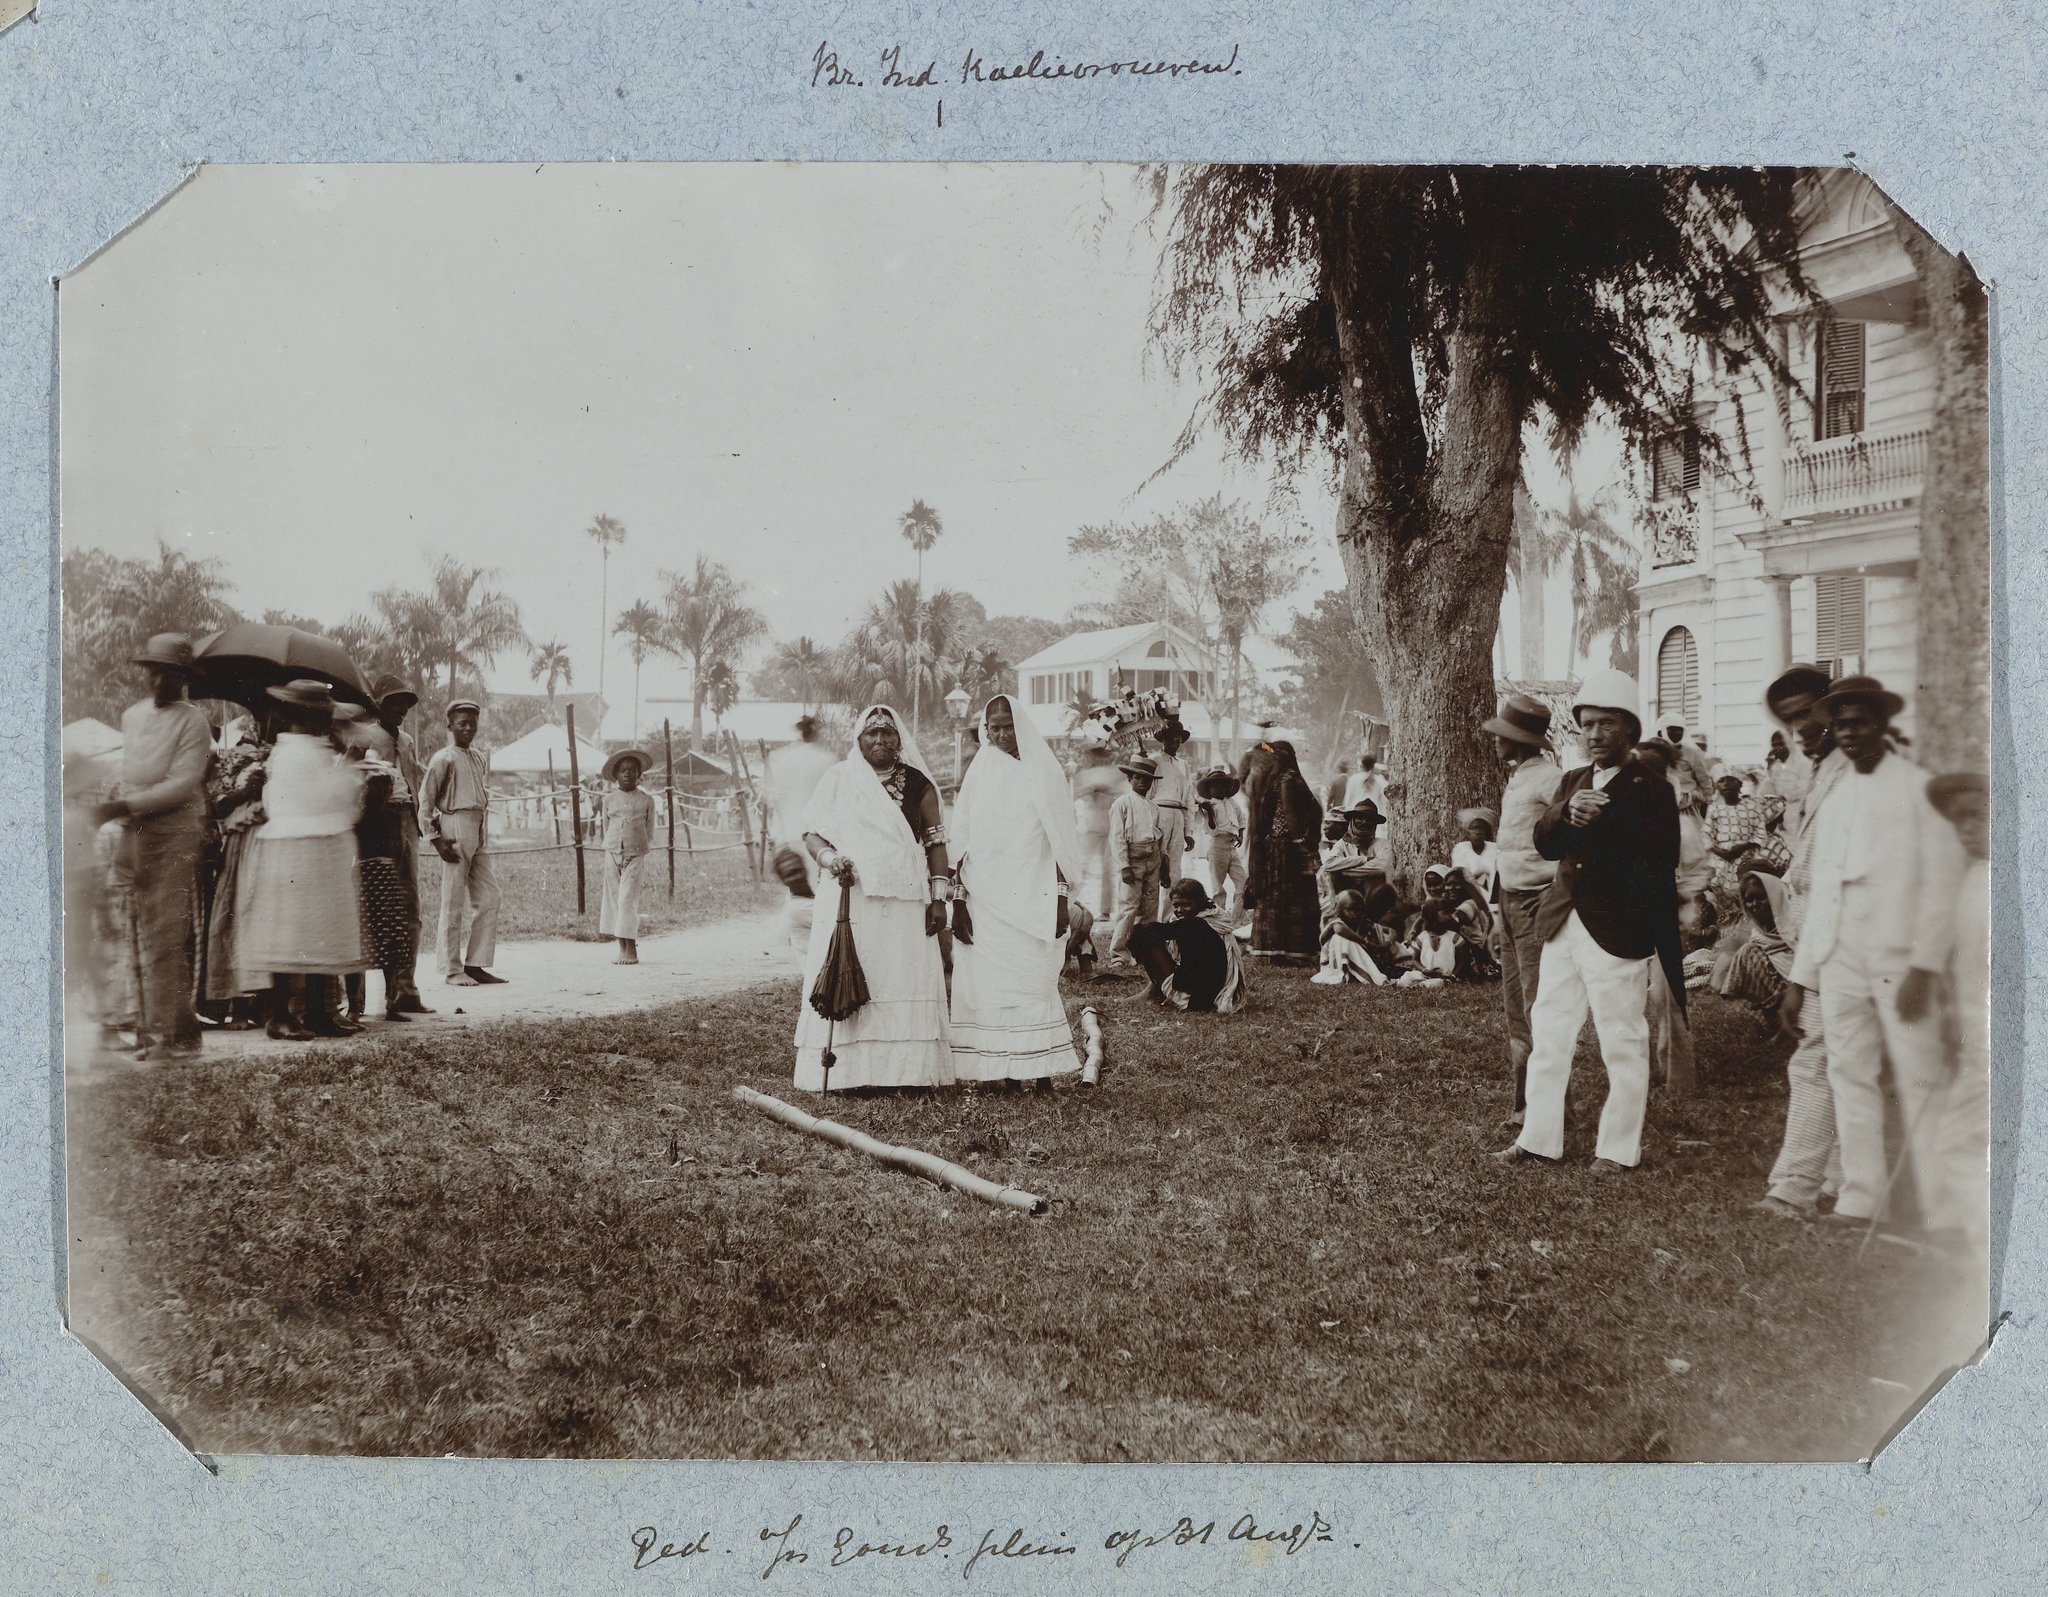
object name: photograph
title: Photographs of Paramaribo and Maroon Village on the Saramacca River, Suriname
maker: théodore van lelyveld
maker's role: painter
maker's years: 1867-1954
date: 1895-1898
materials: photographic support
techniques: collodion silver print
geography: suriname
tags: public festivities on the occasion of royal events, working class, labourers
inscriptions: inscription: ‘Ged. v/h Gouvs.plein op 31 Augs. / Br. Ind. Koelievrouwen’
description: Van Lelyveld left for Suriname as a 28-year old to work as the assistant to the Dutch governor Titus van Asch van Wijck. This presented him with every opportunity to photograph all of the layers of the Surinamese society in the farthest nooks and crannies. Like a seasoned photojournalist he recorded all of the districts of Paramaribo, celebrations on queen’s birthday, population groups and the work camps of the Javanese contract labourers.